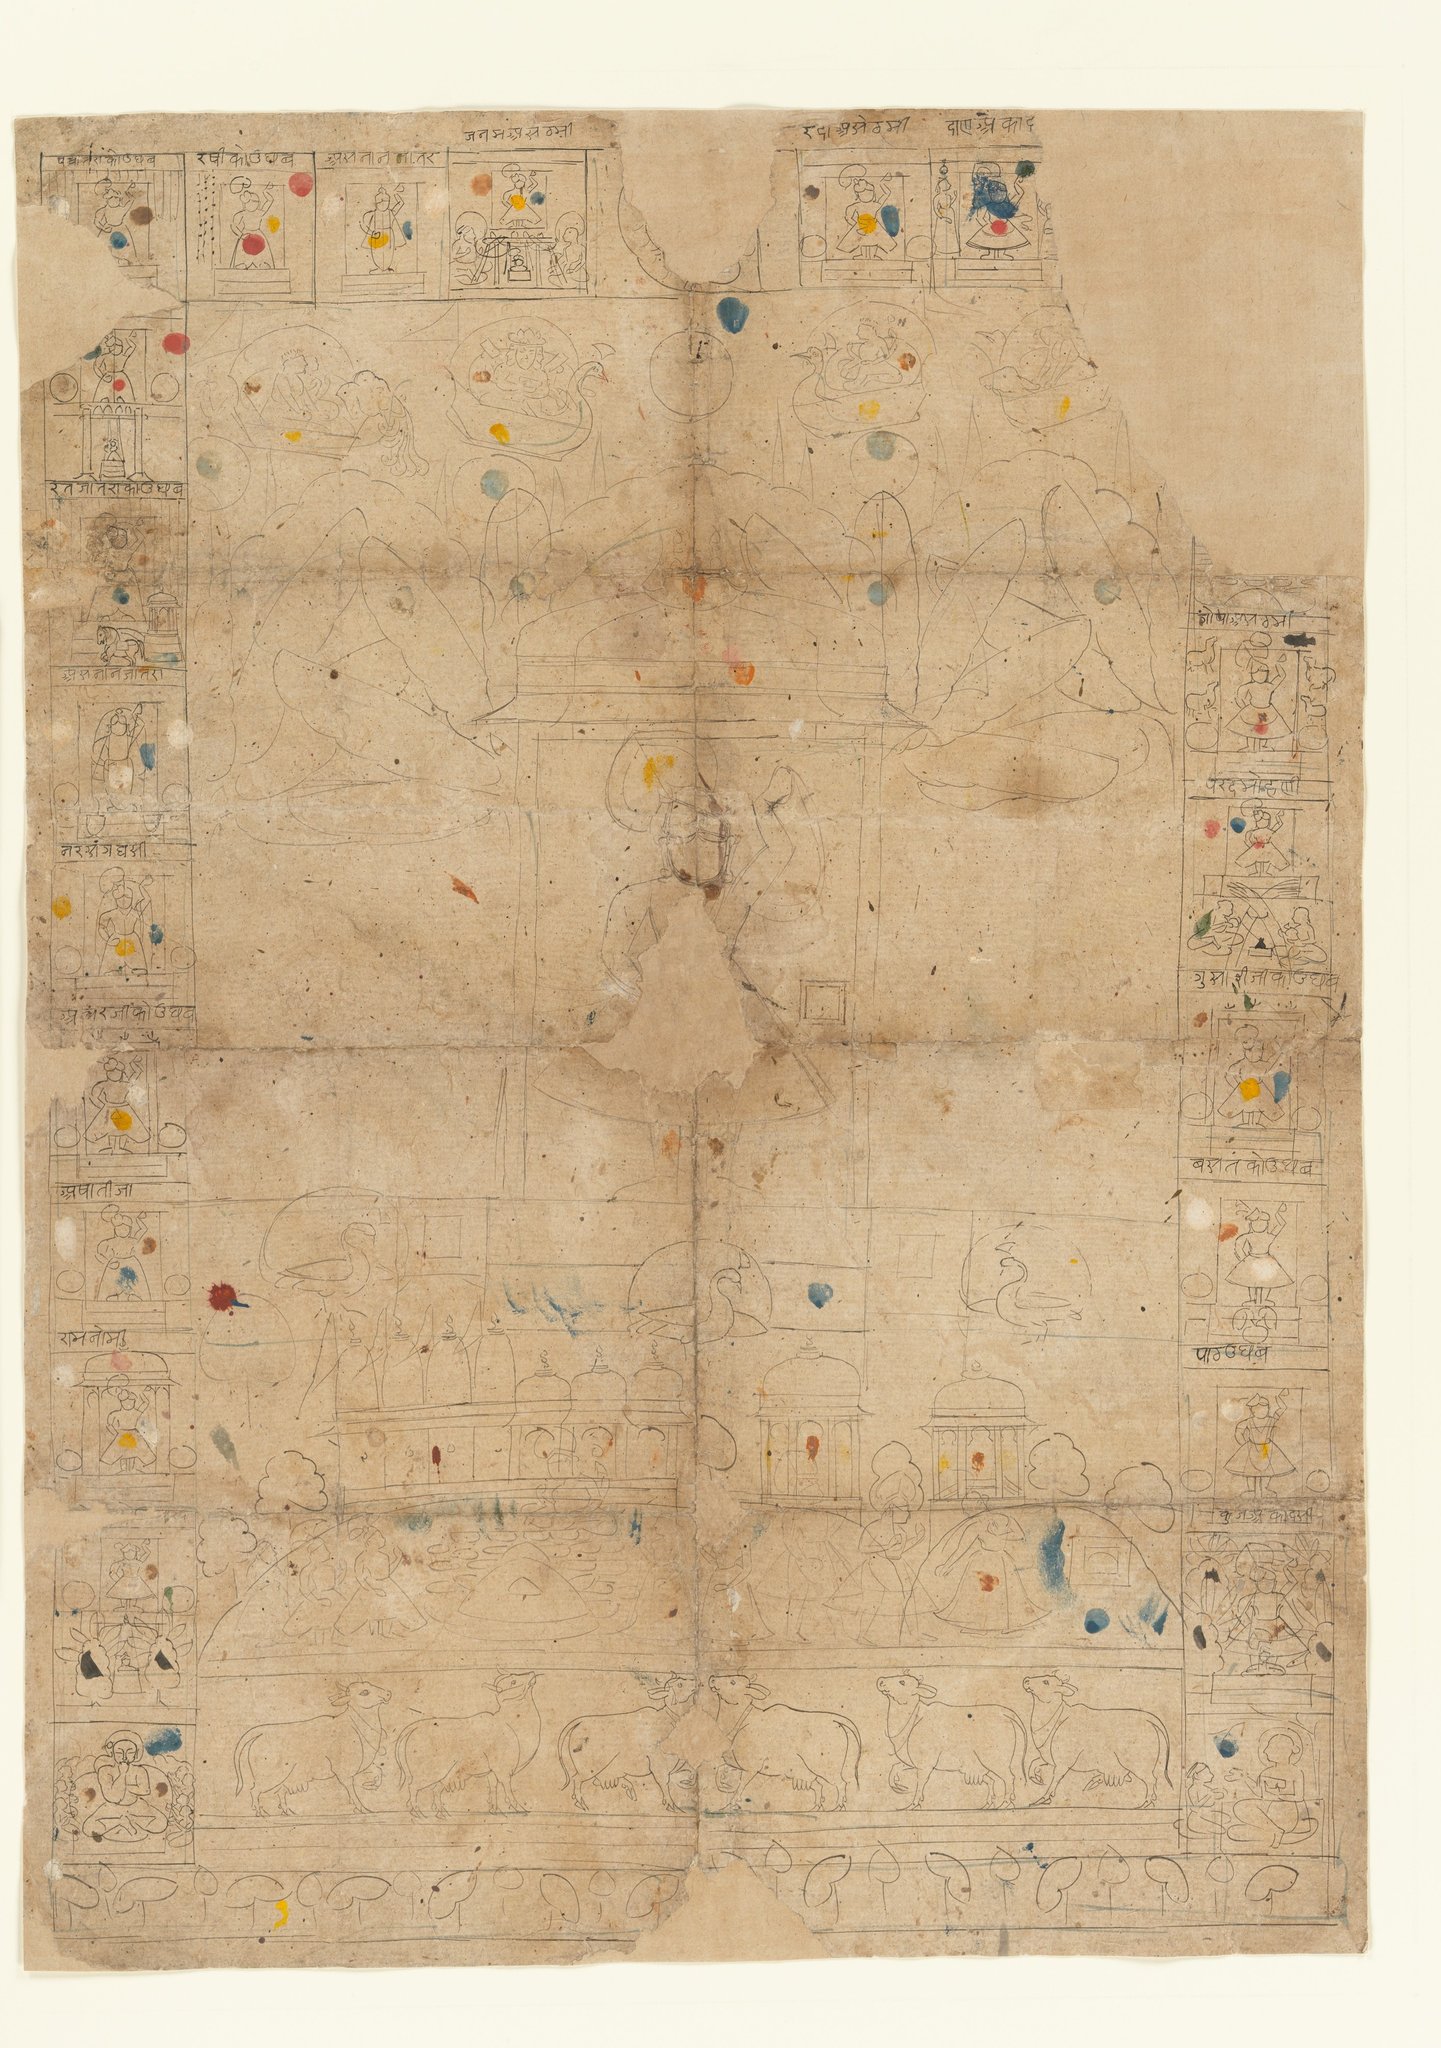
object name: drawing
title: Diagram for a Pichawai Depicting the Sharad Purnima (the Autumn Full Moon)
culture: indian, rajasthani, nathadwara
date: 1834-1866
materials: ink, paper, watercolor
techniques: wash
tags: human figures,birds